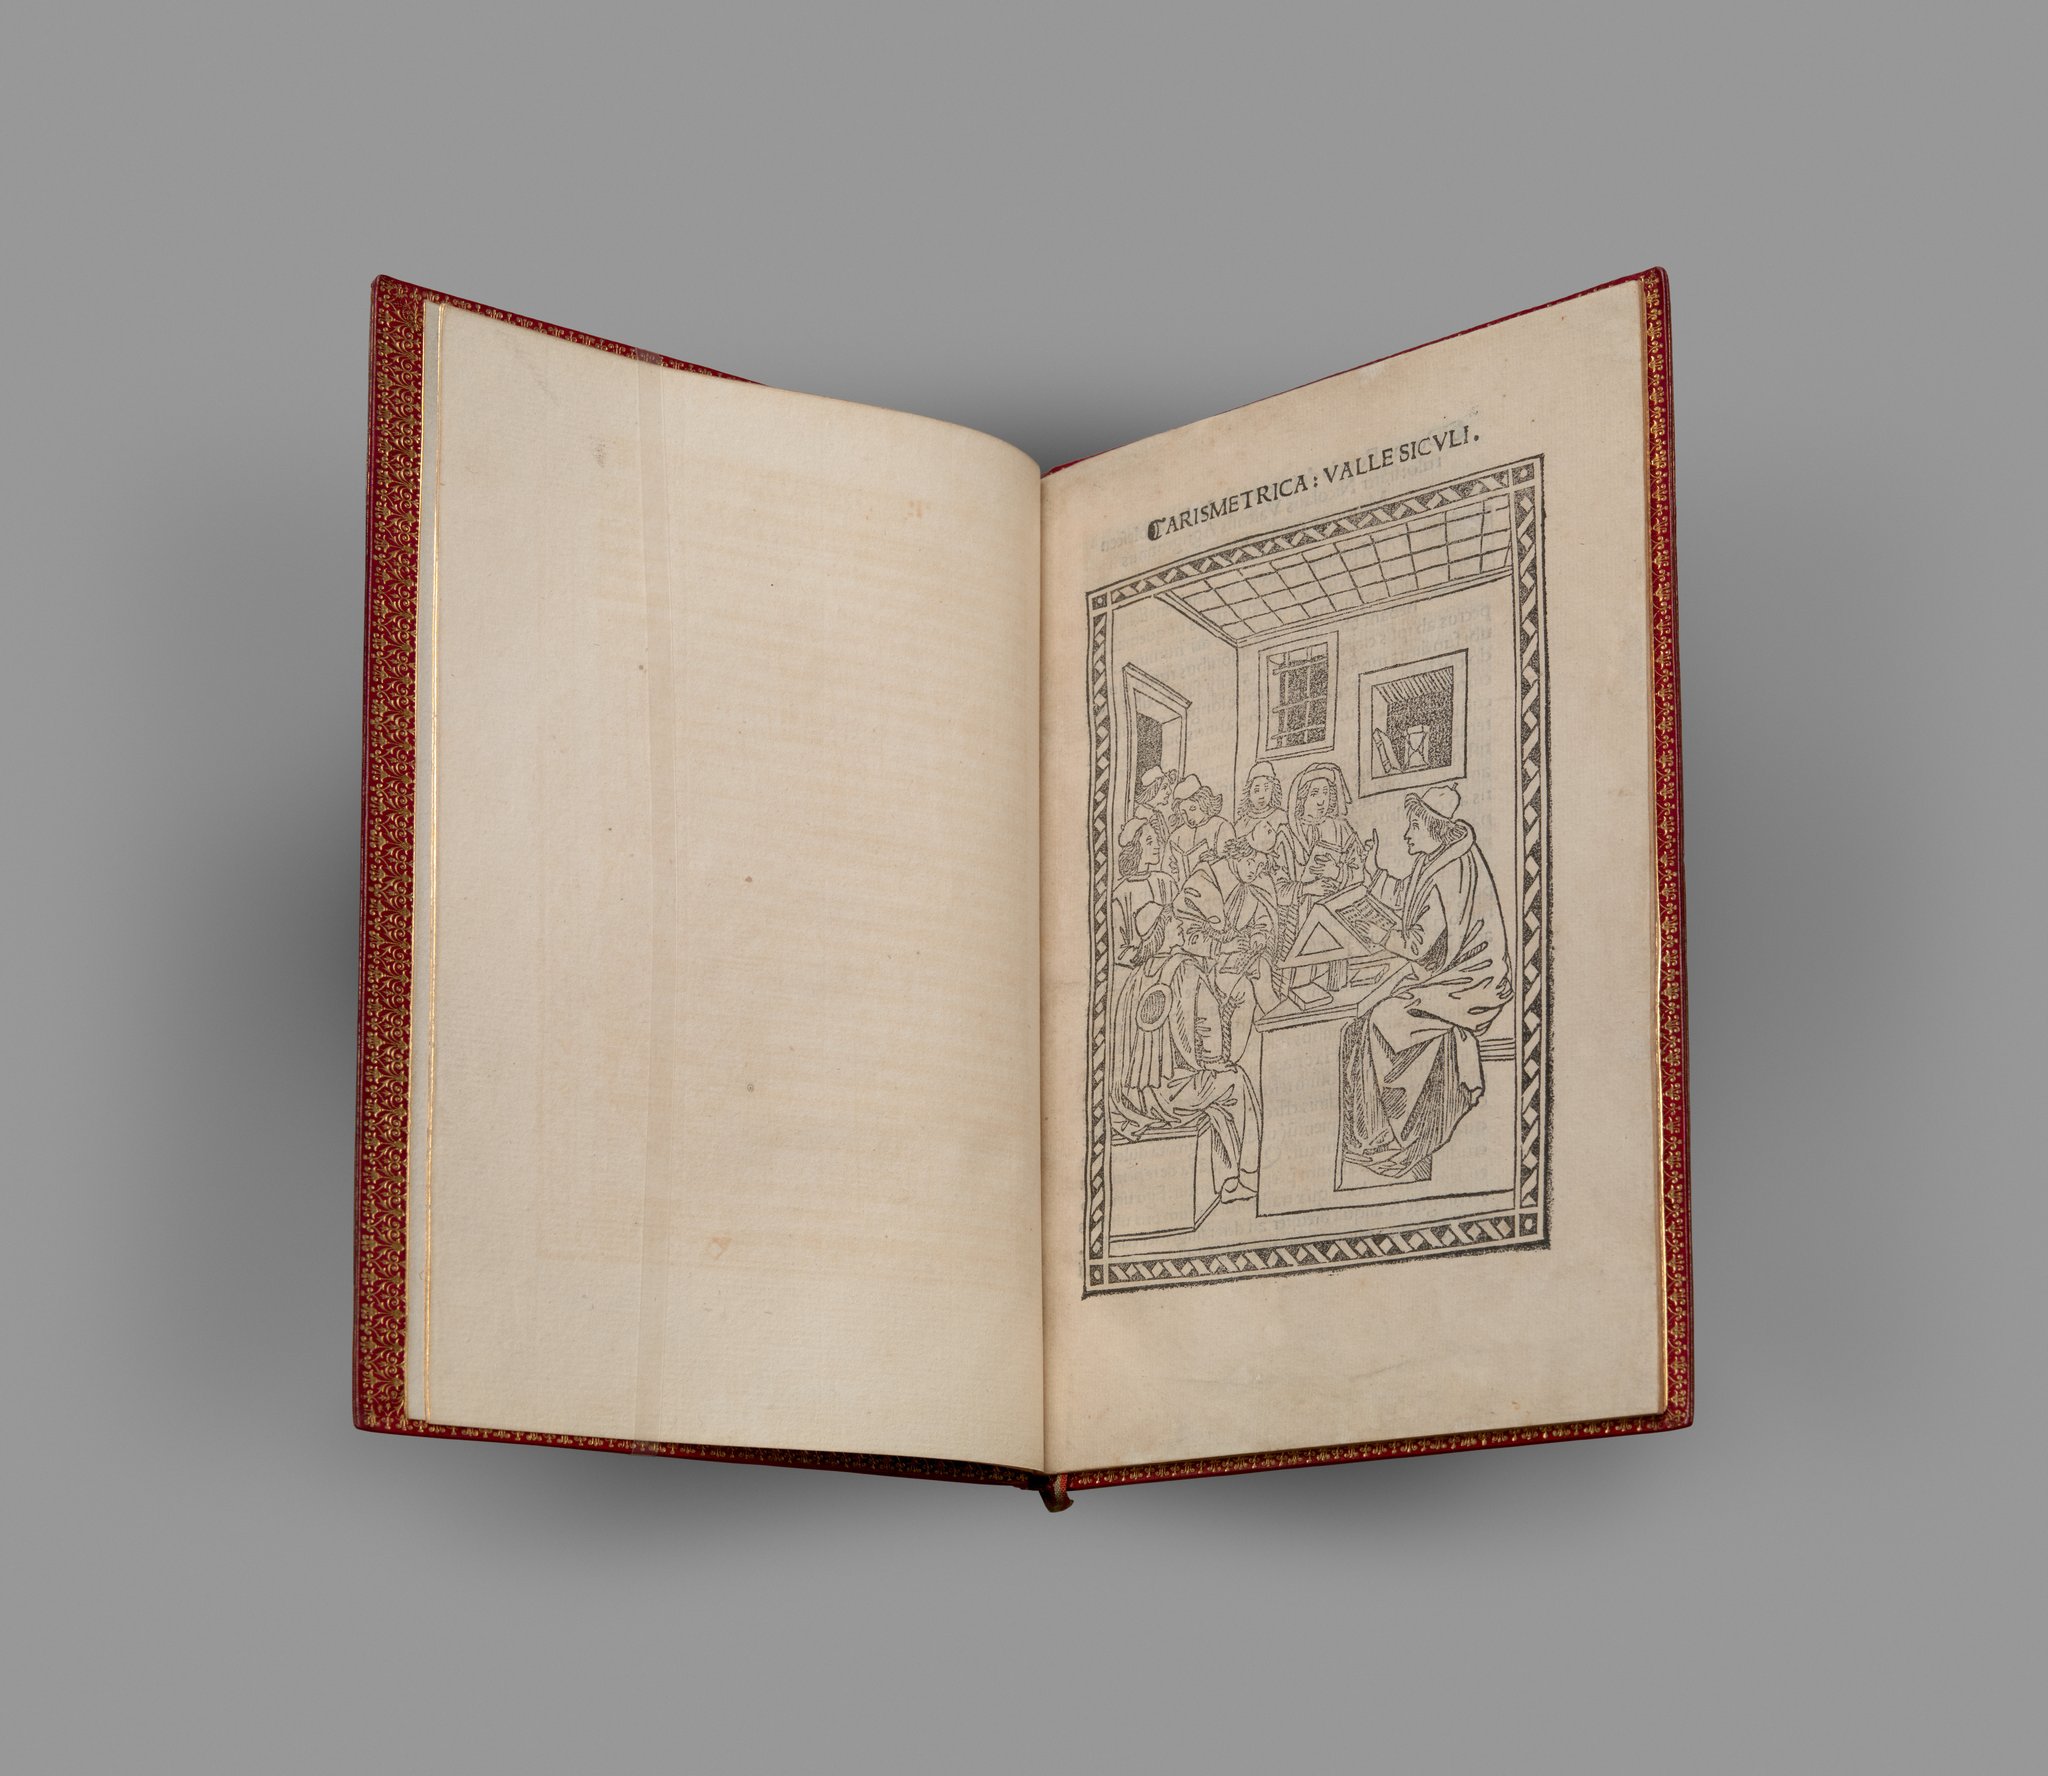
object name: book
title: Arismetrica: Valle Siculi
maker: nicolaus valla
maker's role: author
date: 1490-1500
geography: florence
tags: human figures